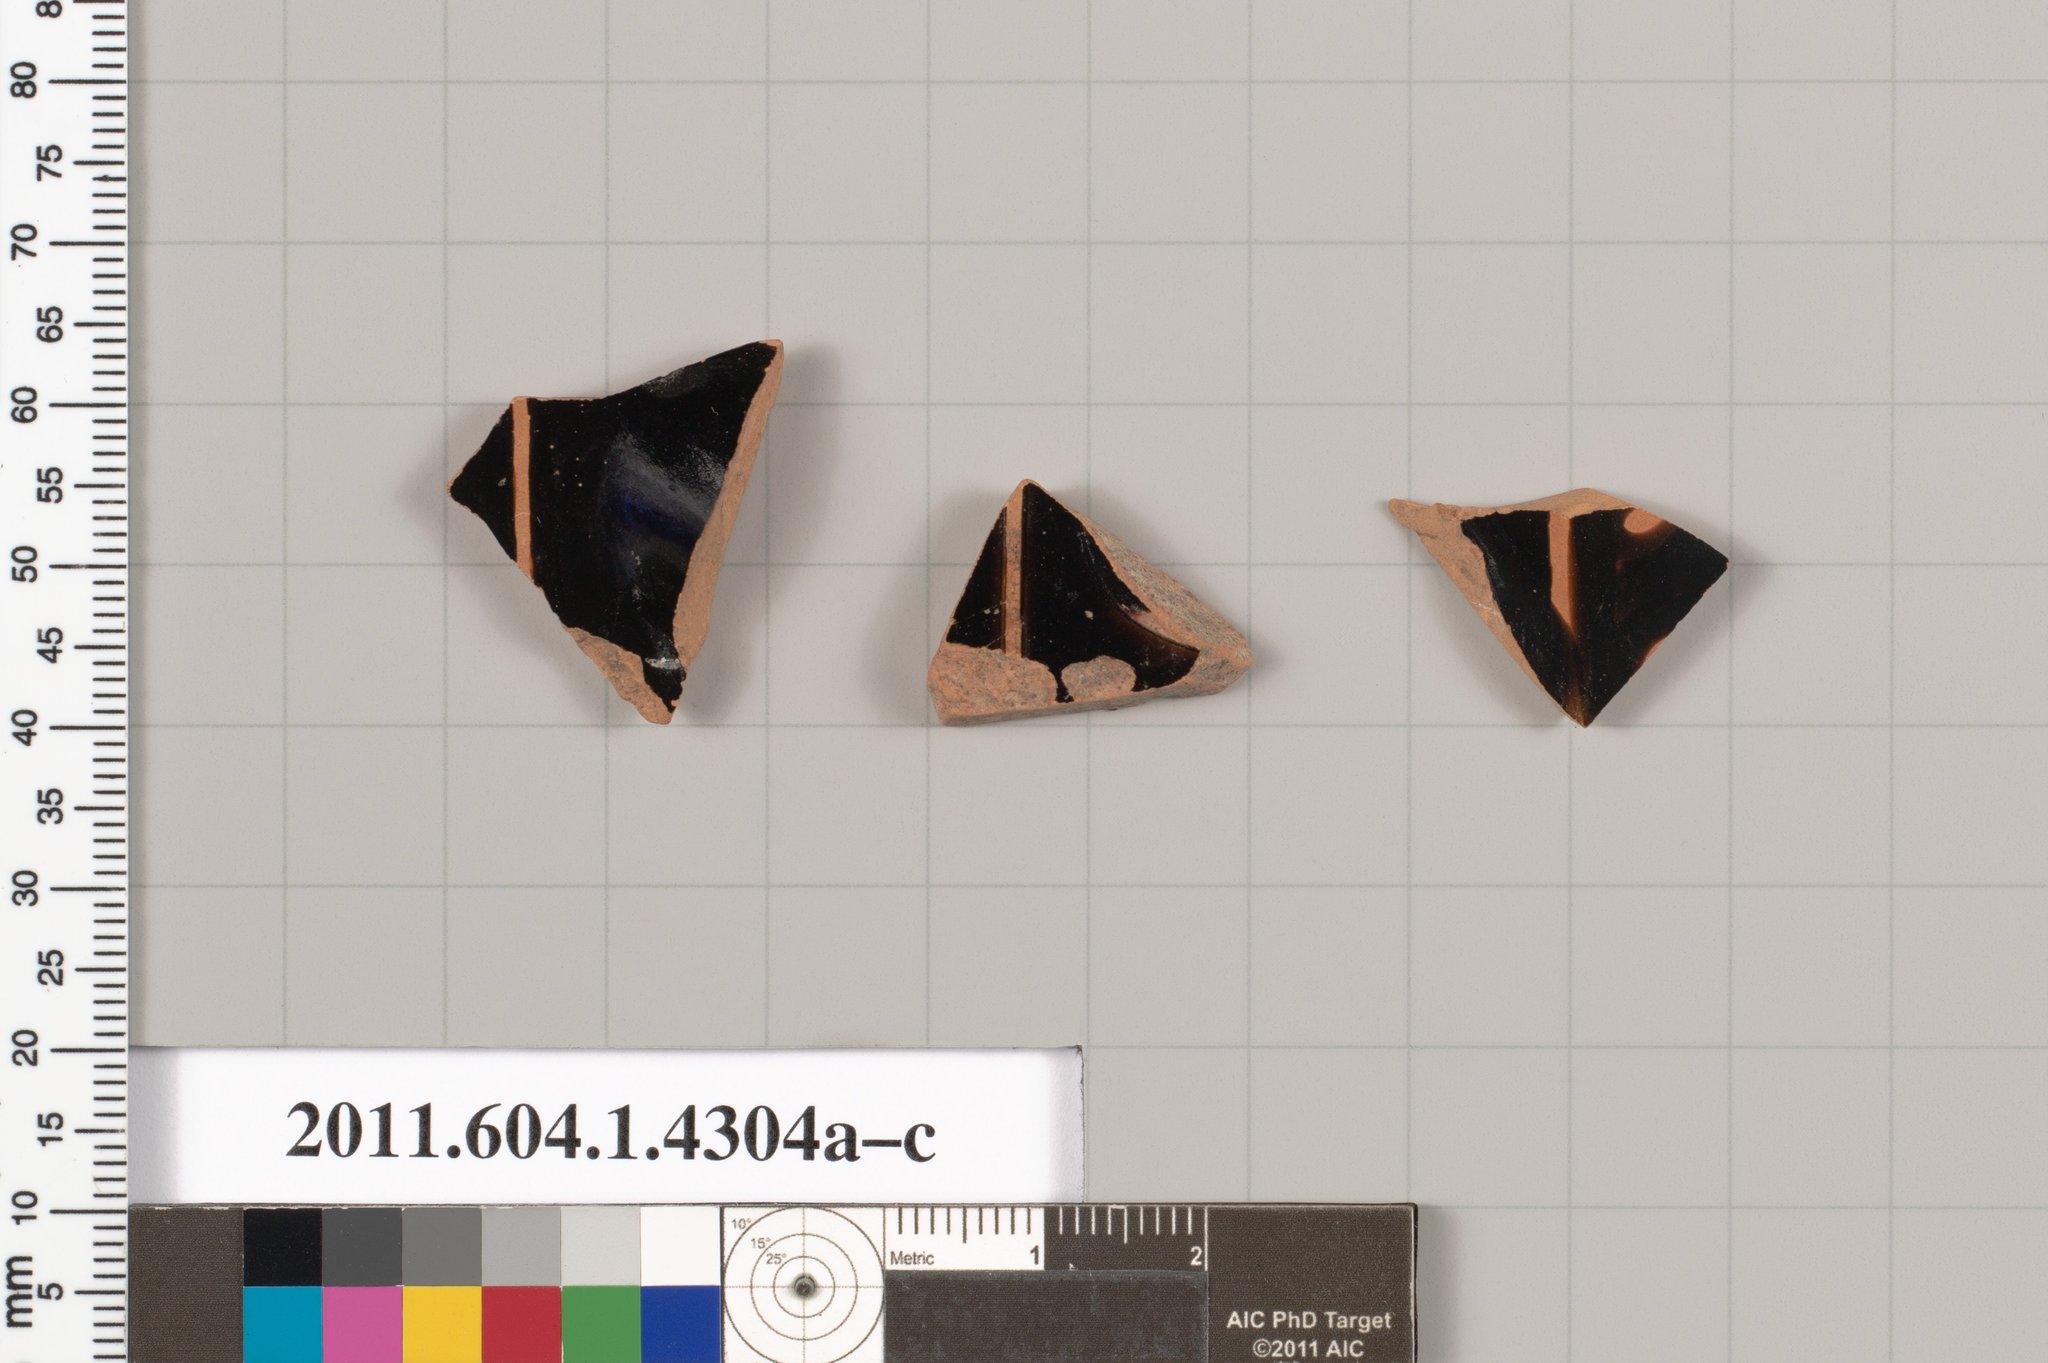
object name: kylix fragment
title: Terracotta fragments of kylikes (drinking cups)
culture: greek, attic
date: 500-451 BCE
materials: terracotta